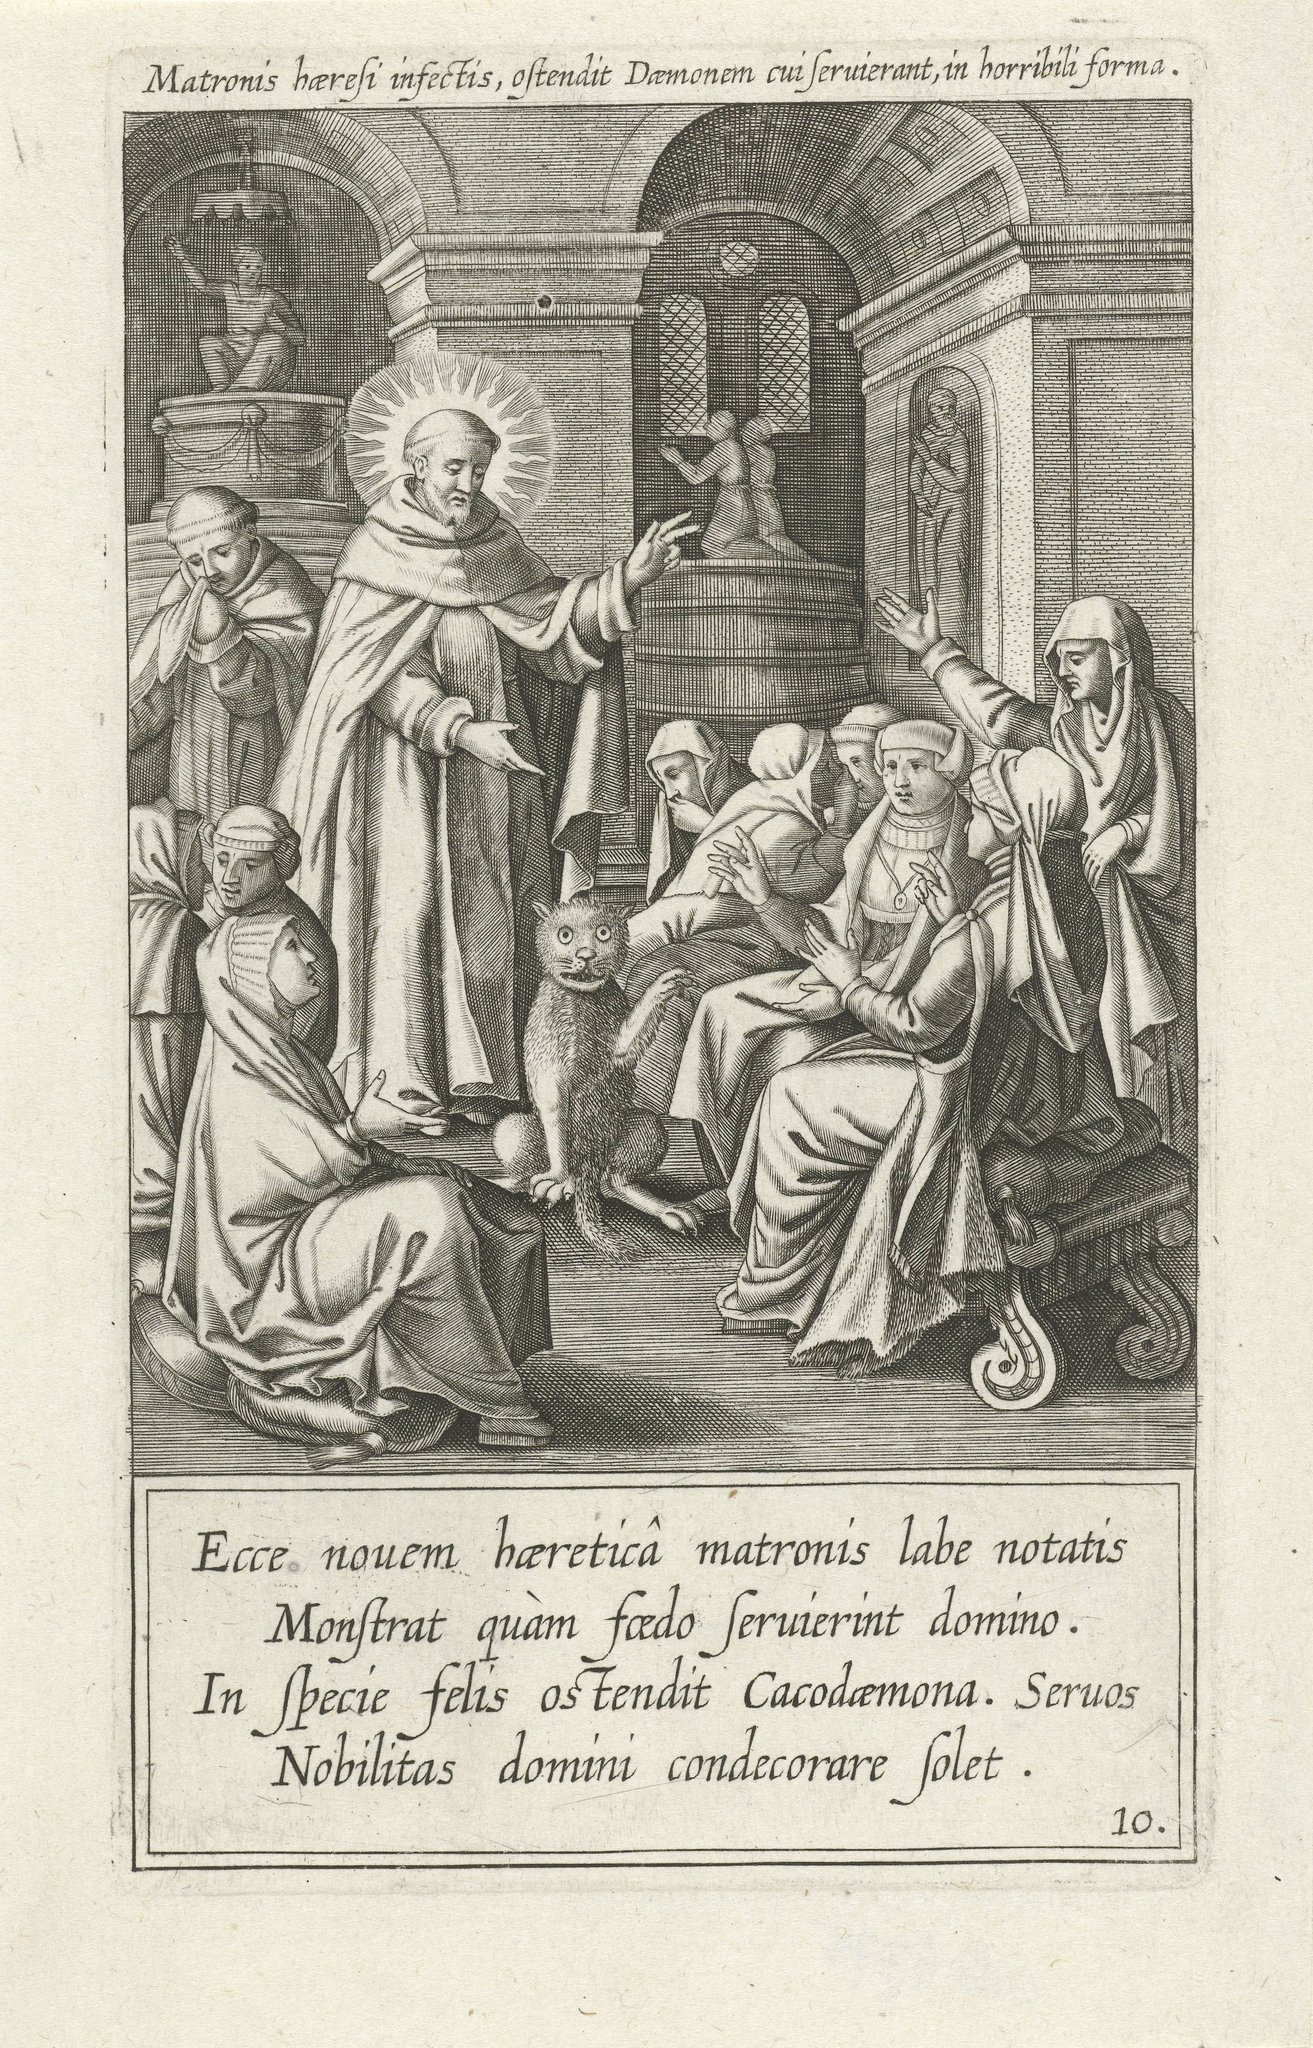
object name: print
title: Vita et miracula S.P. Dominici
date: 1611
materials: paper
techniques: engraving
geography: antwerp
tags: specific aspects ~ st. dominic - male saint as patron, protector, intercessor (+ devil(s))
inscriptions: collector's mark: Lugt 2228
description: De Heilige Dominicus drijft een duivel uit een kerk, die de gedaante heeft aangenomen van een enorme kat. De prent heeft een Latijns opschrift en onderschrift en maakt deel uit van een prentserie voor een boek over het leven van de heilige Dominicus.